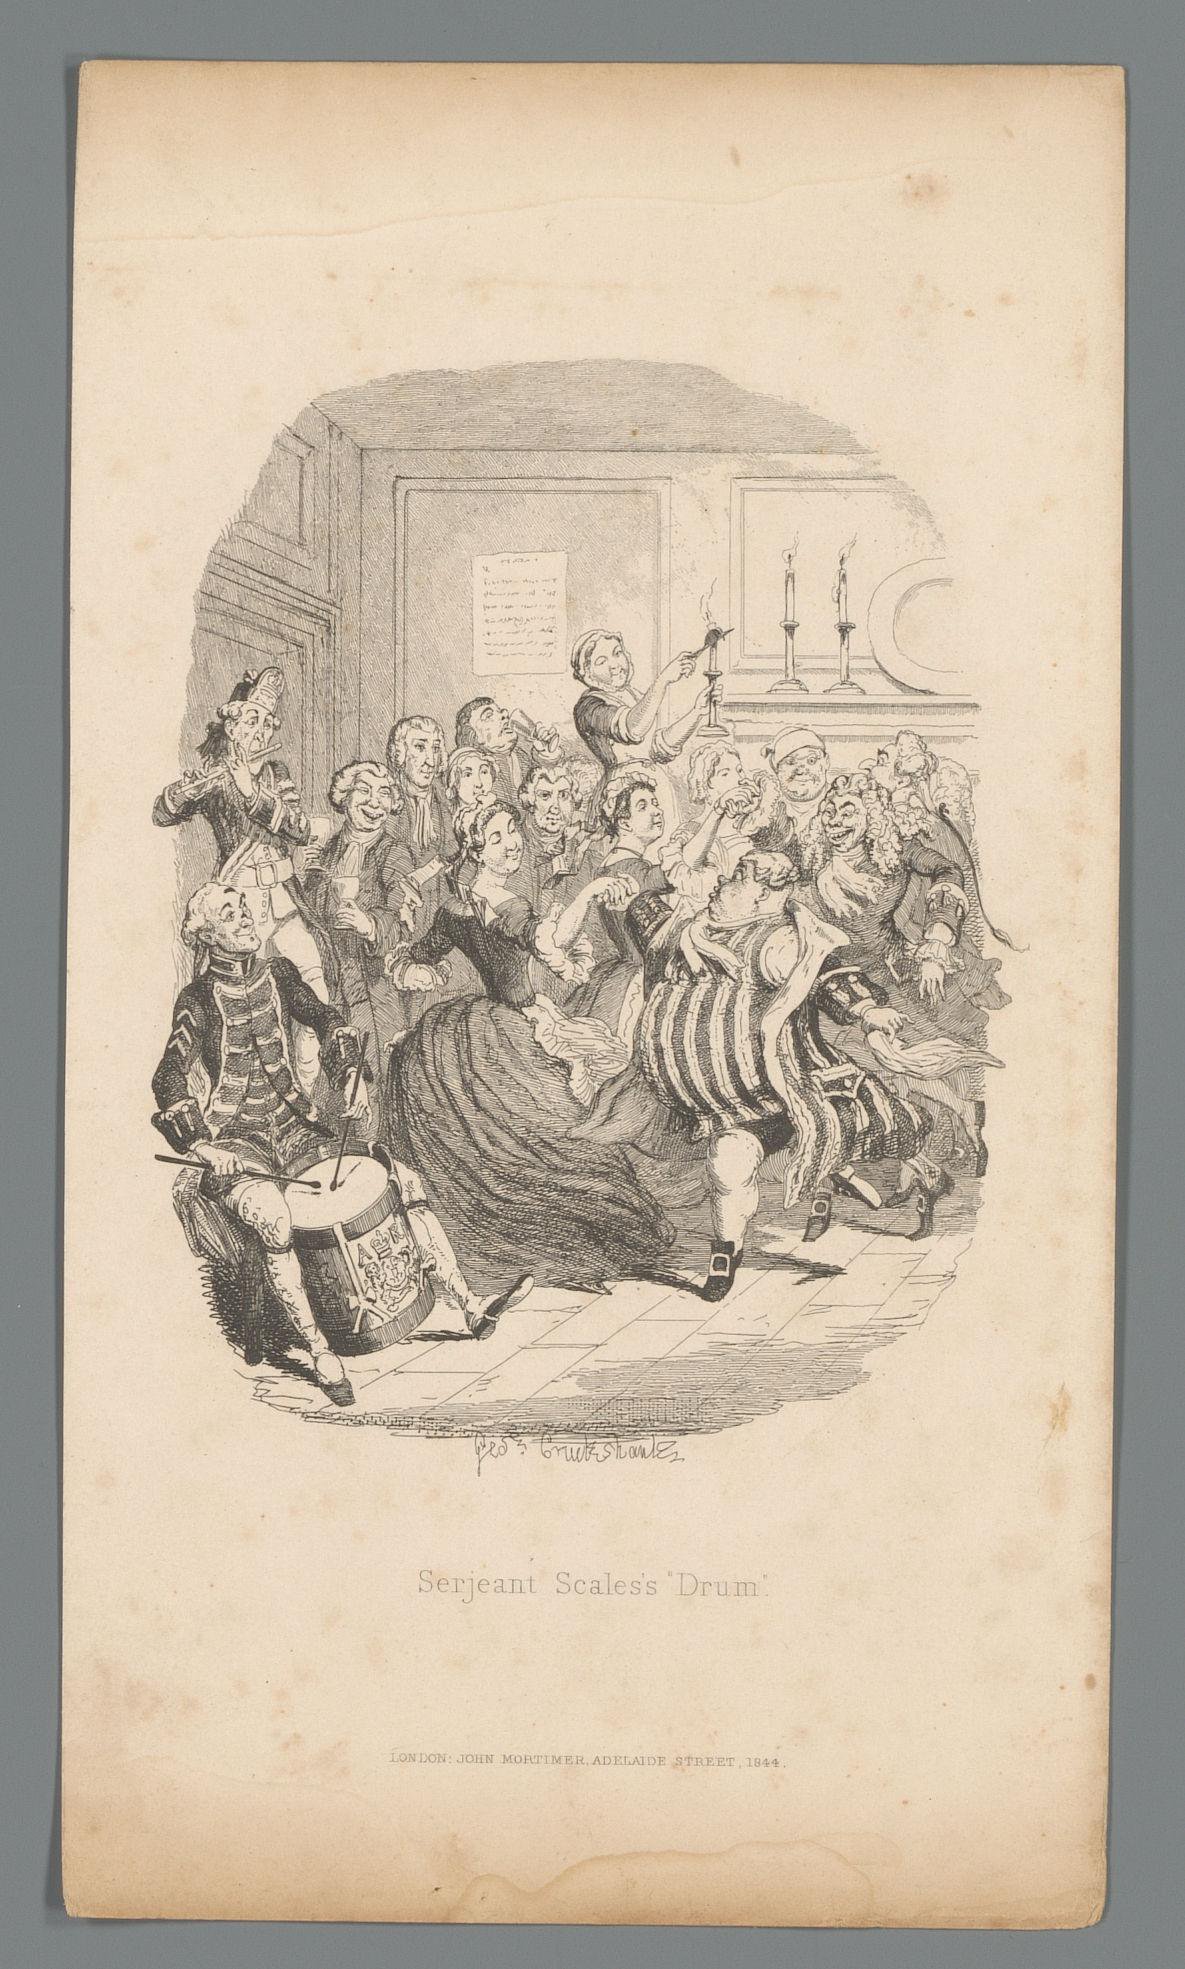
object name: cartoon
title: Sergeant Scales speelt de trommel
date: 1844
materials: paper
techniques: etching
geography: england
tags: folk dancing (men and women together), drum (musical instrument), political caricatures and satires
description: Sergeant Scales speelt op de trommel voor het dansende gezelschap. Illustratie voor een uitgave van "St James's, or the Court of Queen Anne" van Ainsworth, 1844.